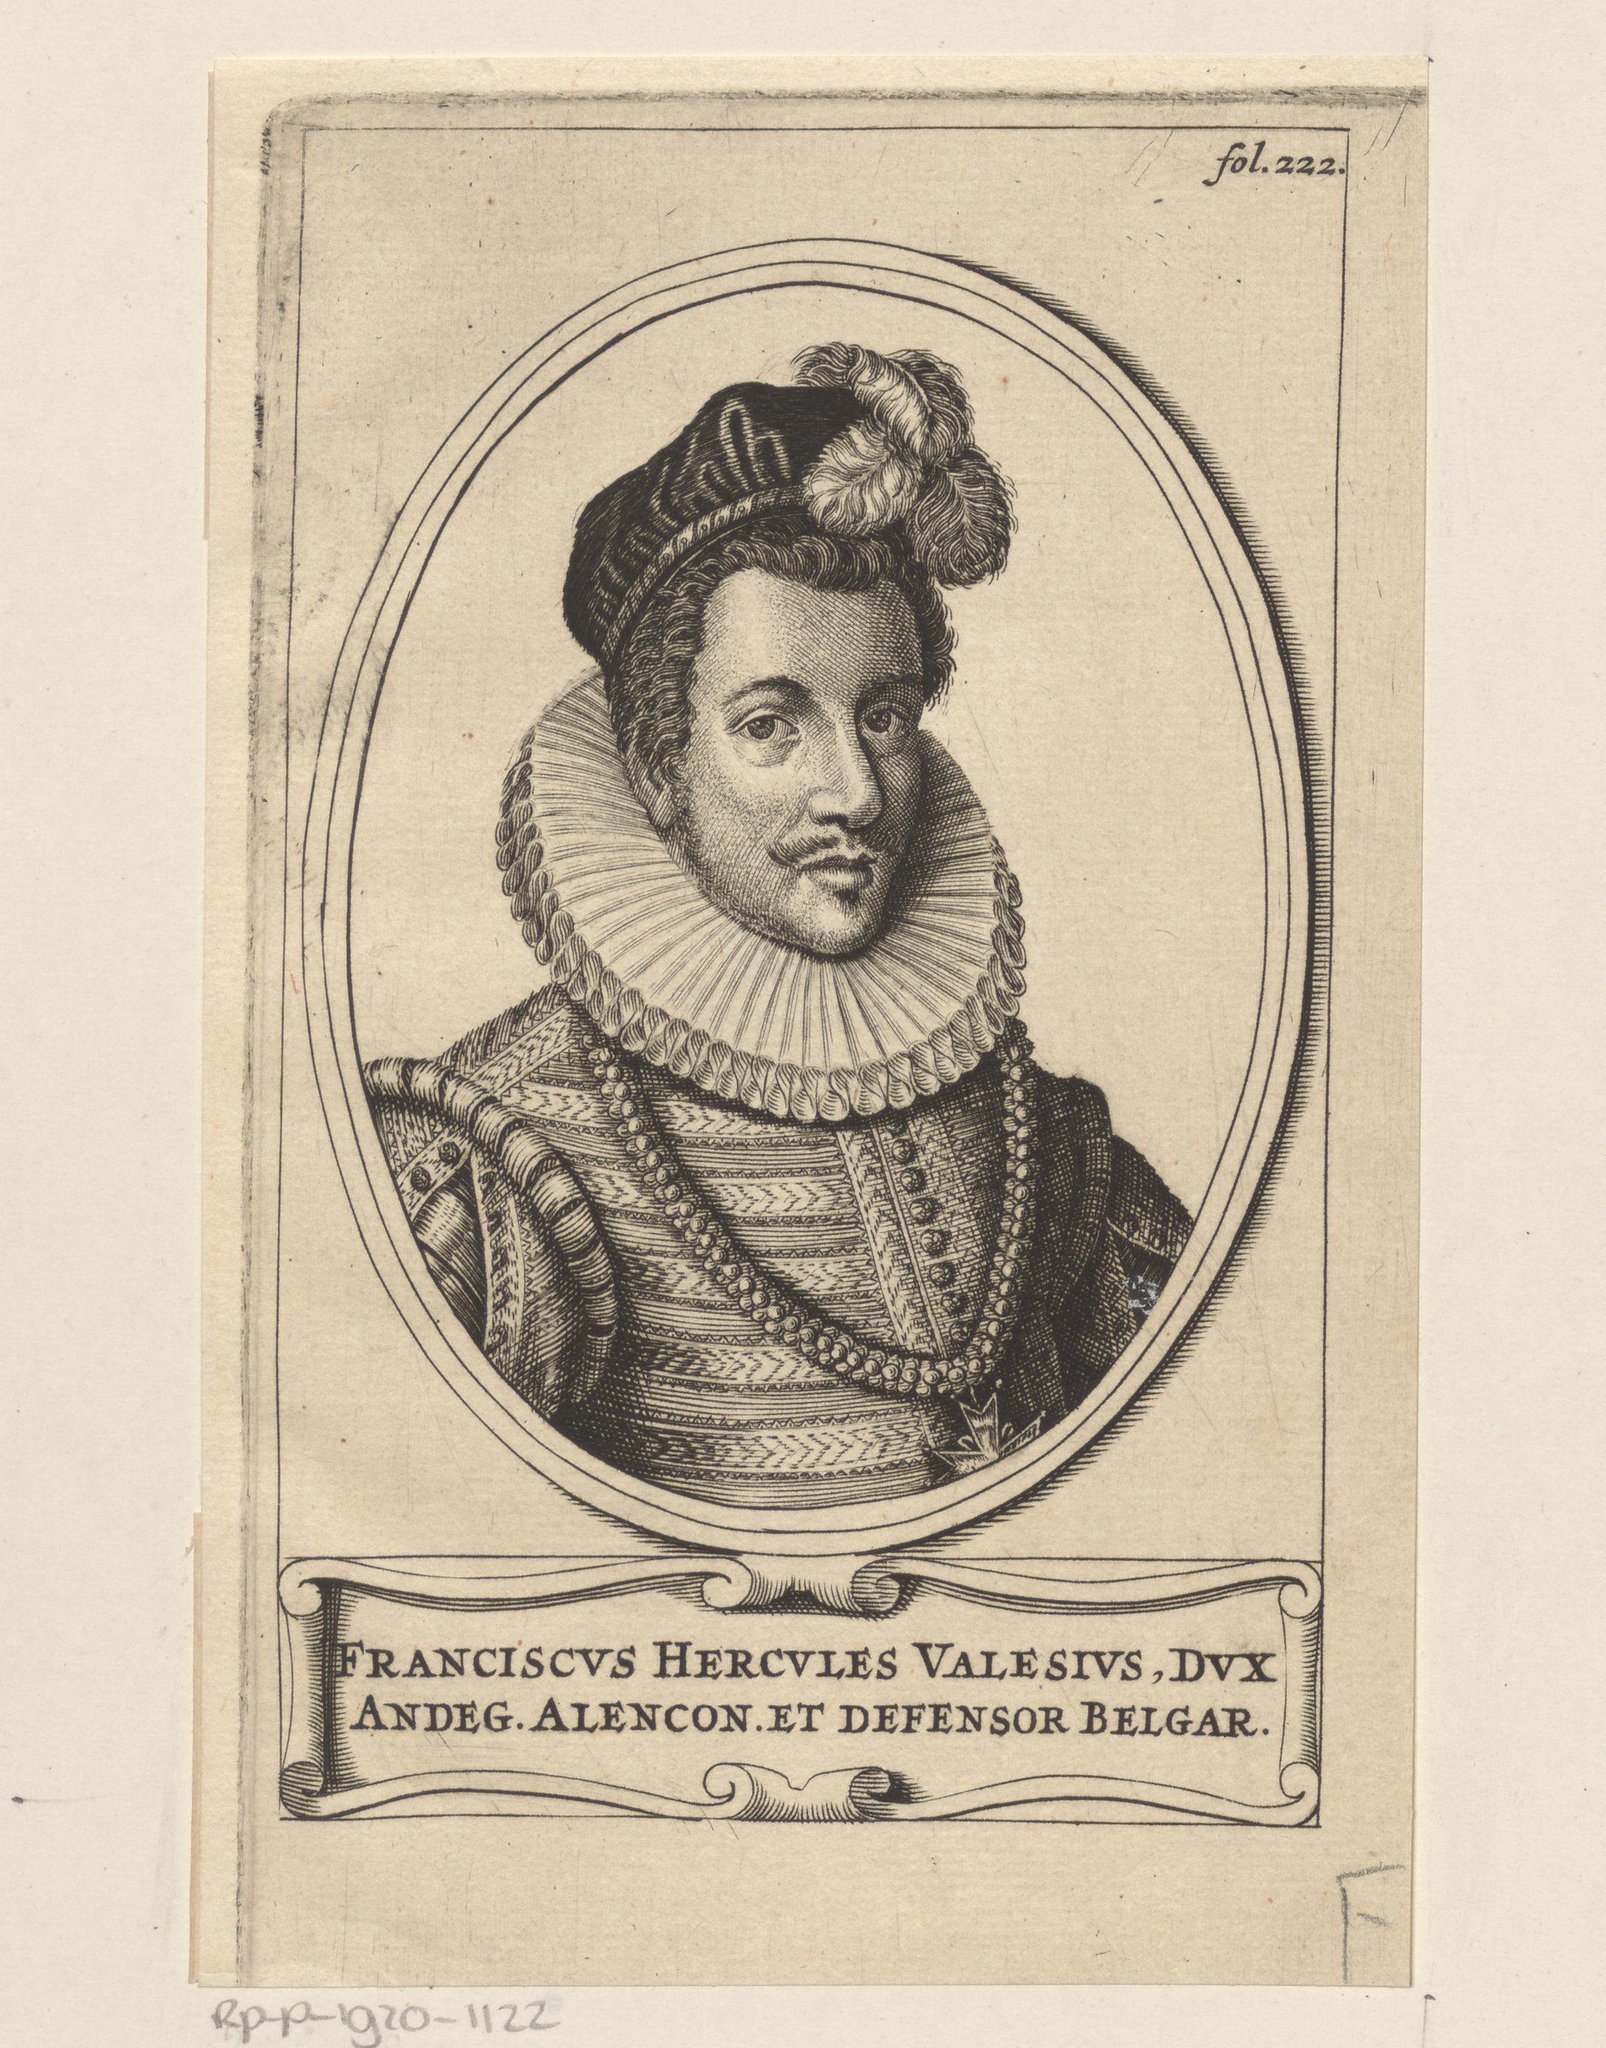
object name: book illustration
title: Portret van François-Hercule de Valois, hertog van Anjou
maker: Anonymous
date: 1600-1699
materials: paper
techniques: engraving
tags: paris, françois-hercule de valois (hertog van anjou)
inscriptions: collector's mark: Lugt 2228